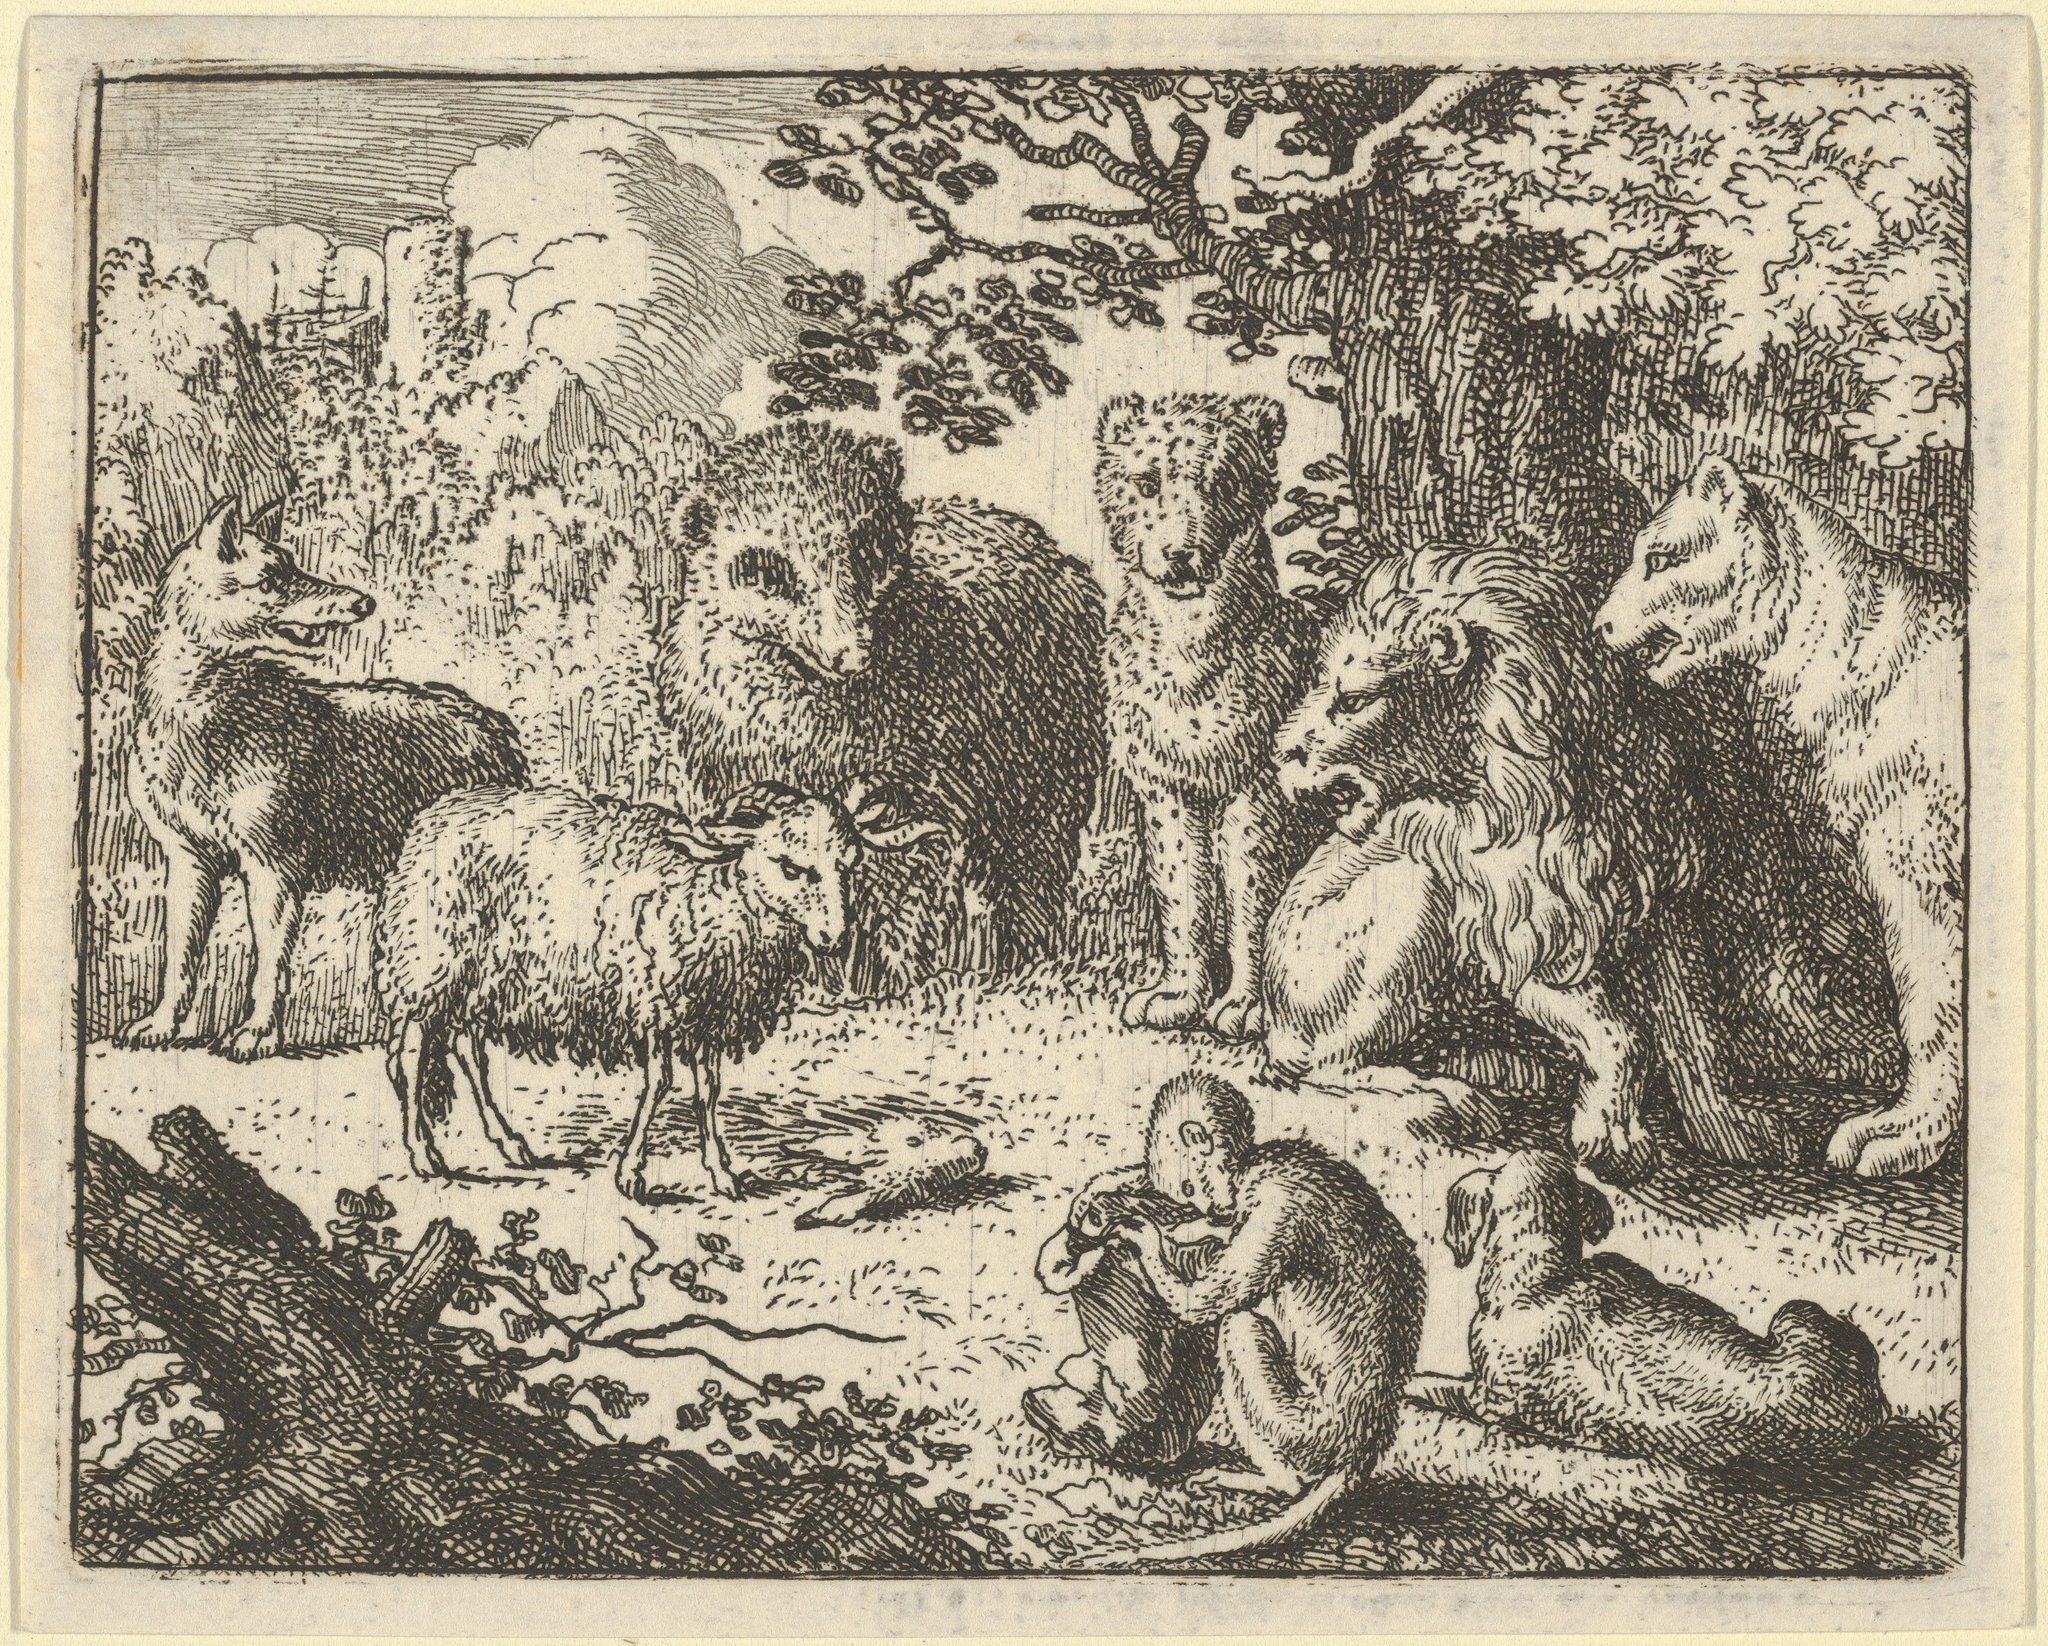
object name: print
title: The Monkey Opens the Package and Removes the Rabbit's Head to the Great Surprise of the Animals from Hendrick van Alcmar's Renard The Fox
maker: allart van everdingen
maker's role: artist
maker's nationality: dutch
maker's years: 1621-1675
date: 1650-1675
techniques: engraving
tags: animals,landscapes,trees